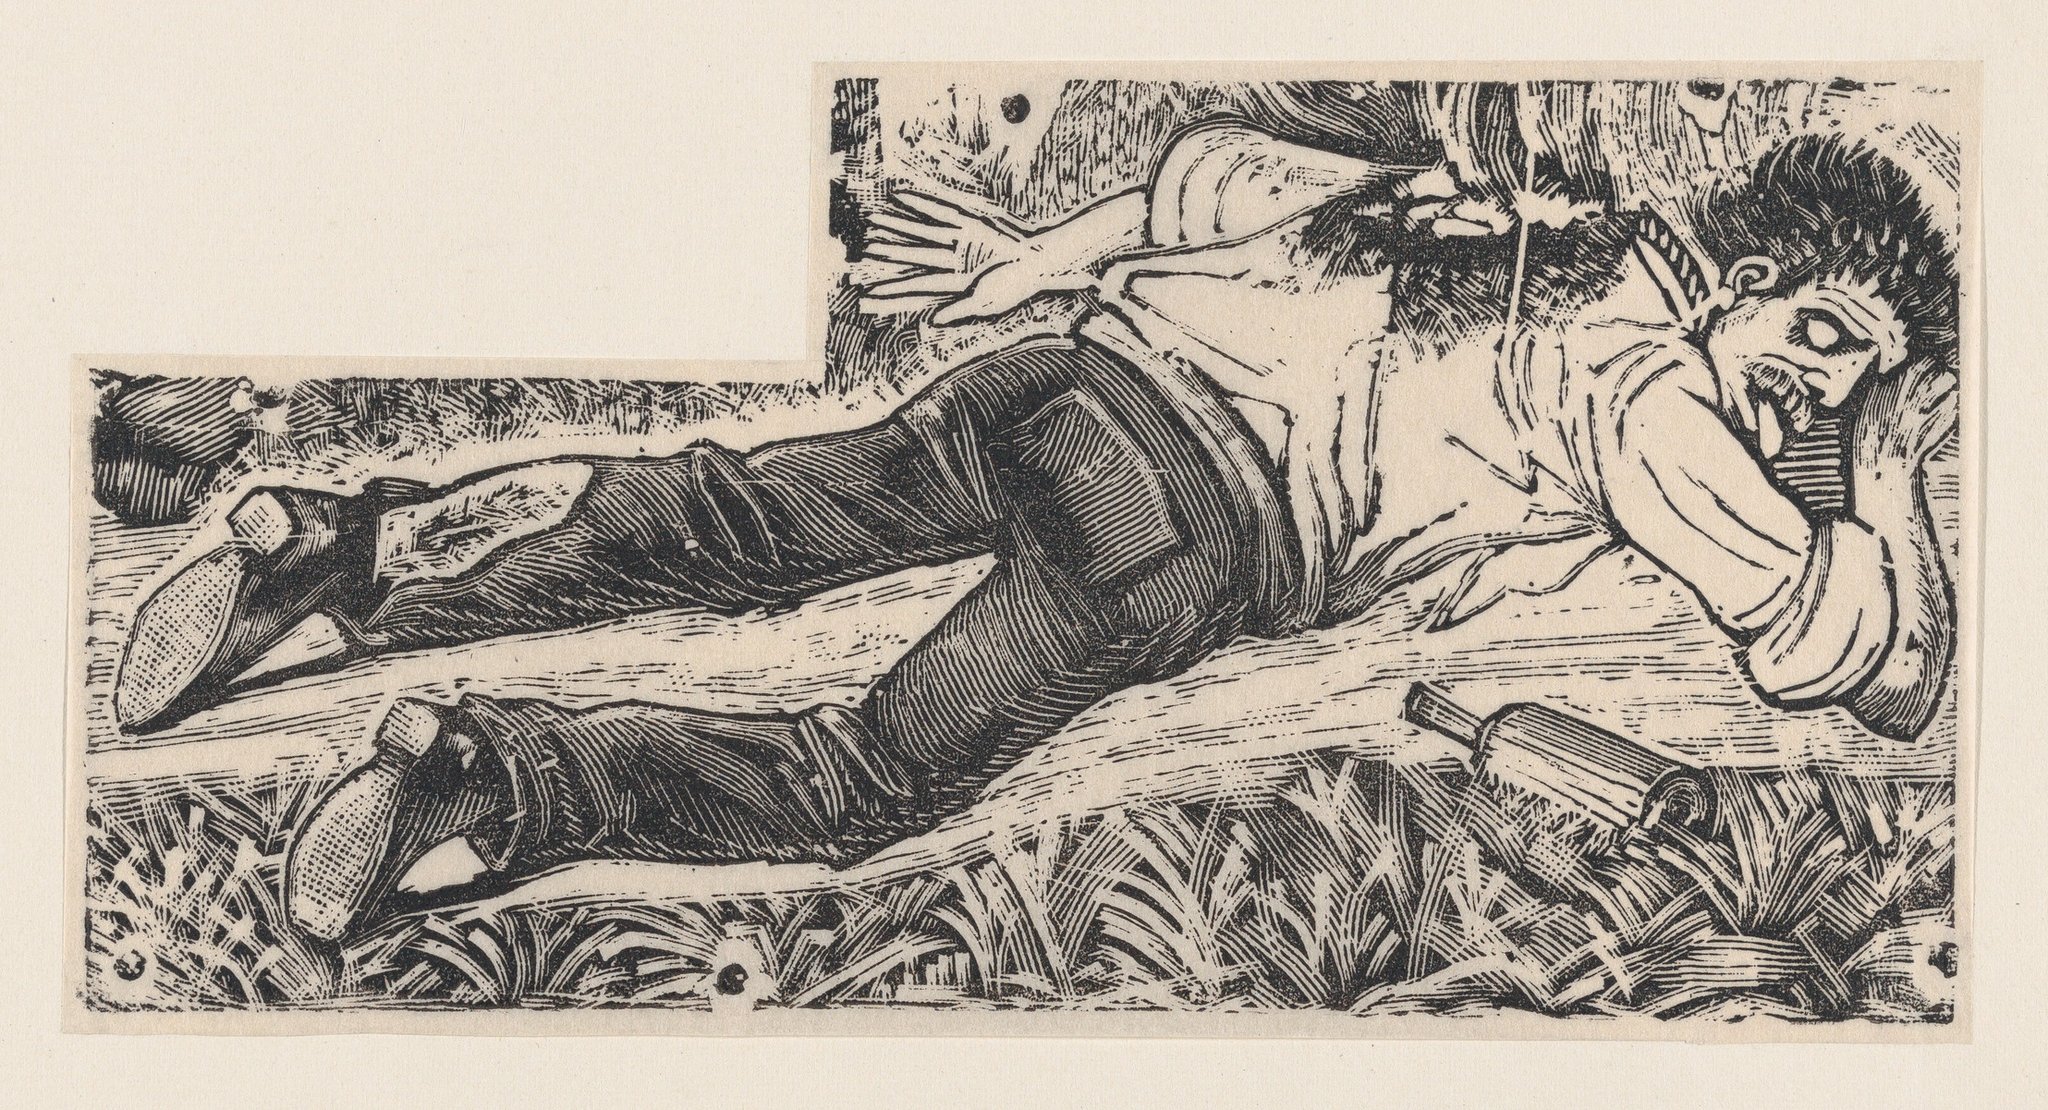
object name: print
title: A drunken man with a bottle at his side in a field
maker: josé guadalupe posada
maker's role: artist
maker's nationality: mexican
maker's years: 1852-1913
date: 1880-1910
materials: metal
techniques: engraving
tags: drunkenness,men